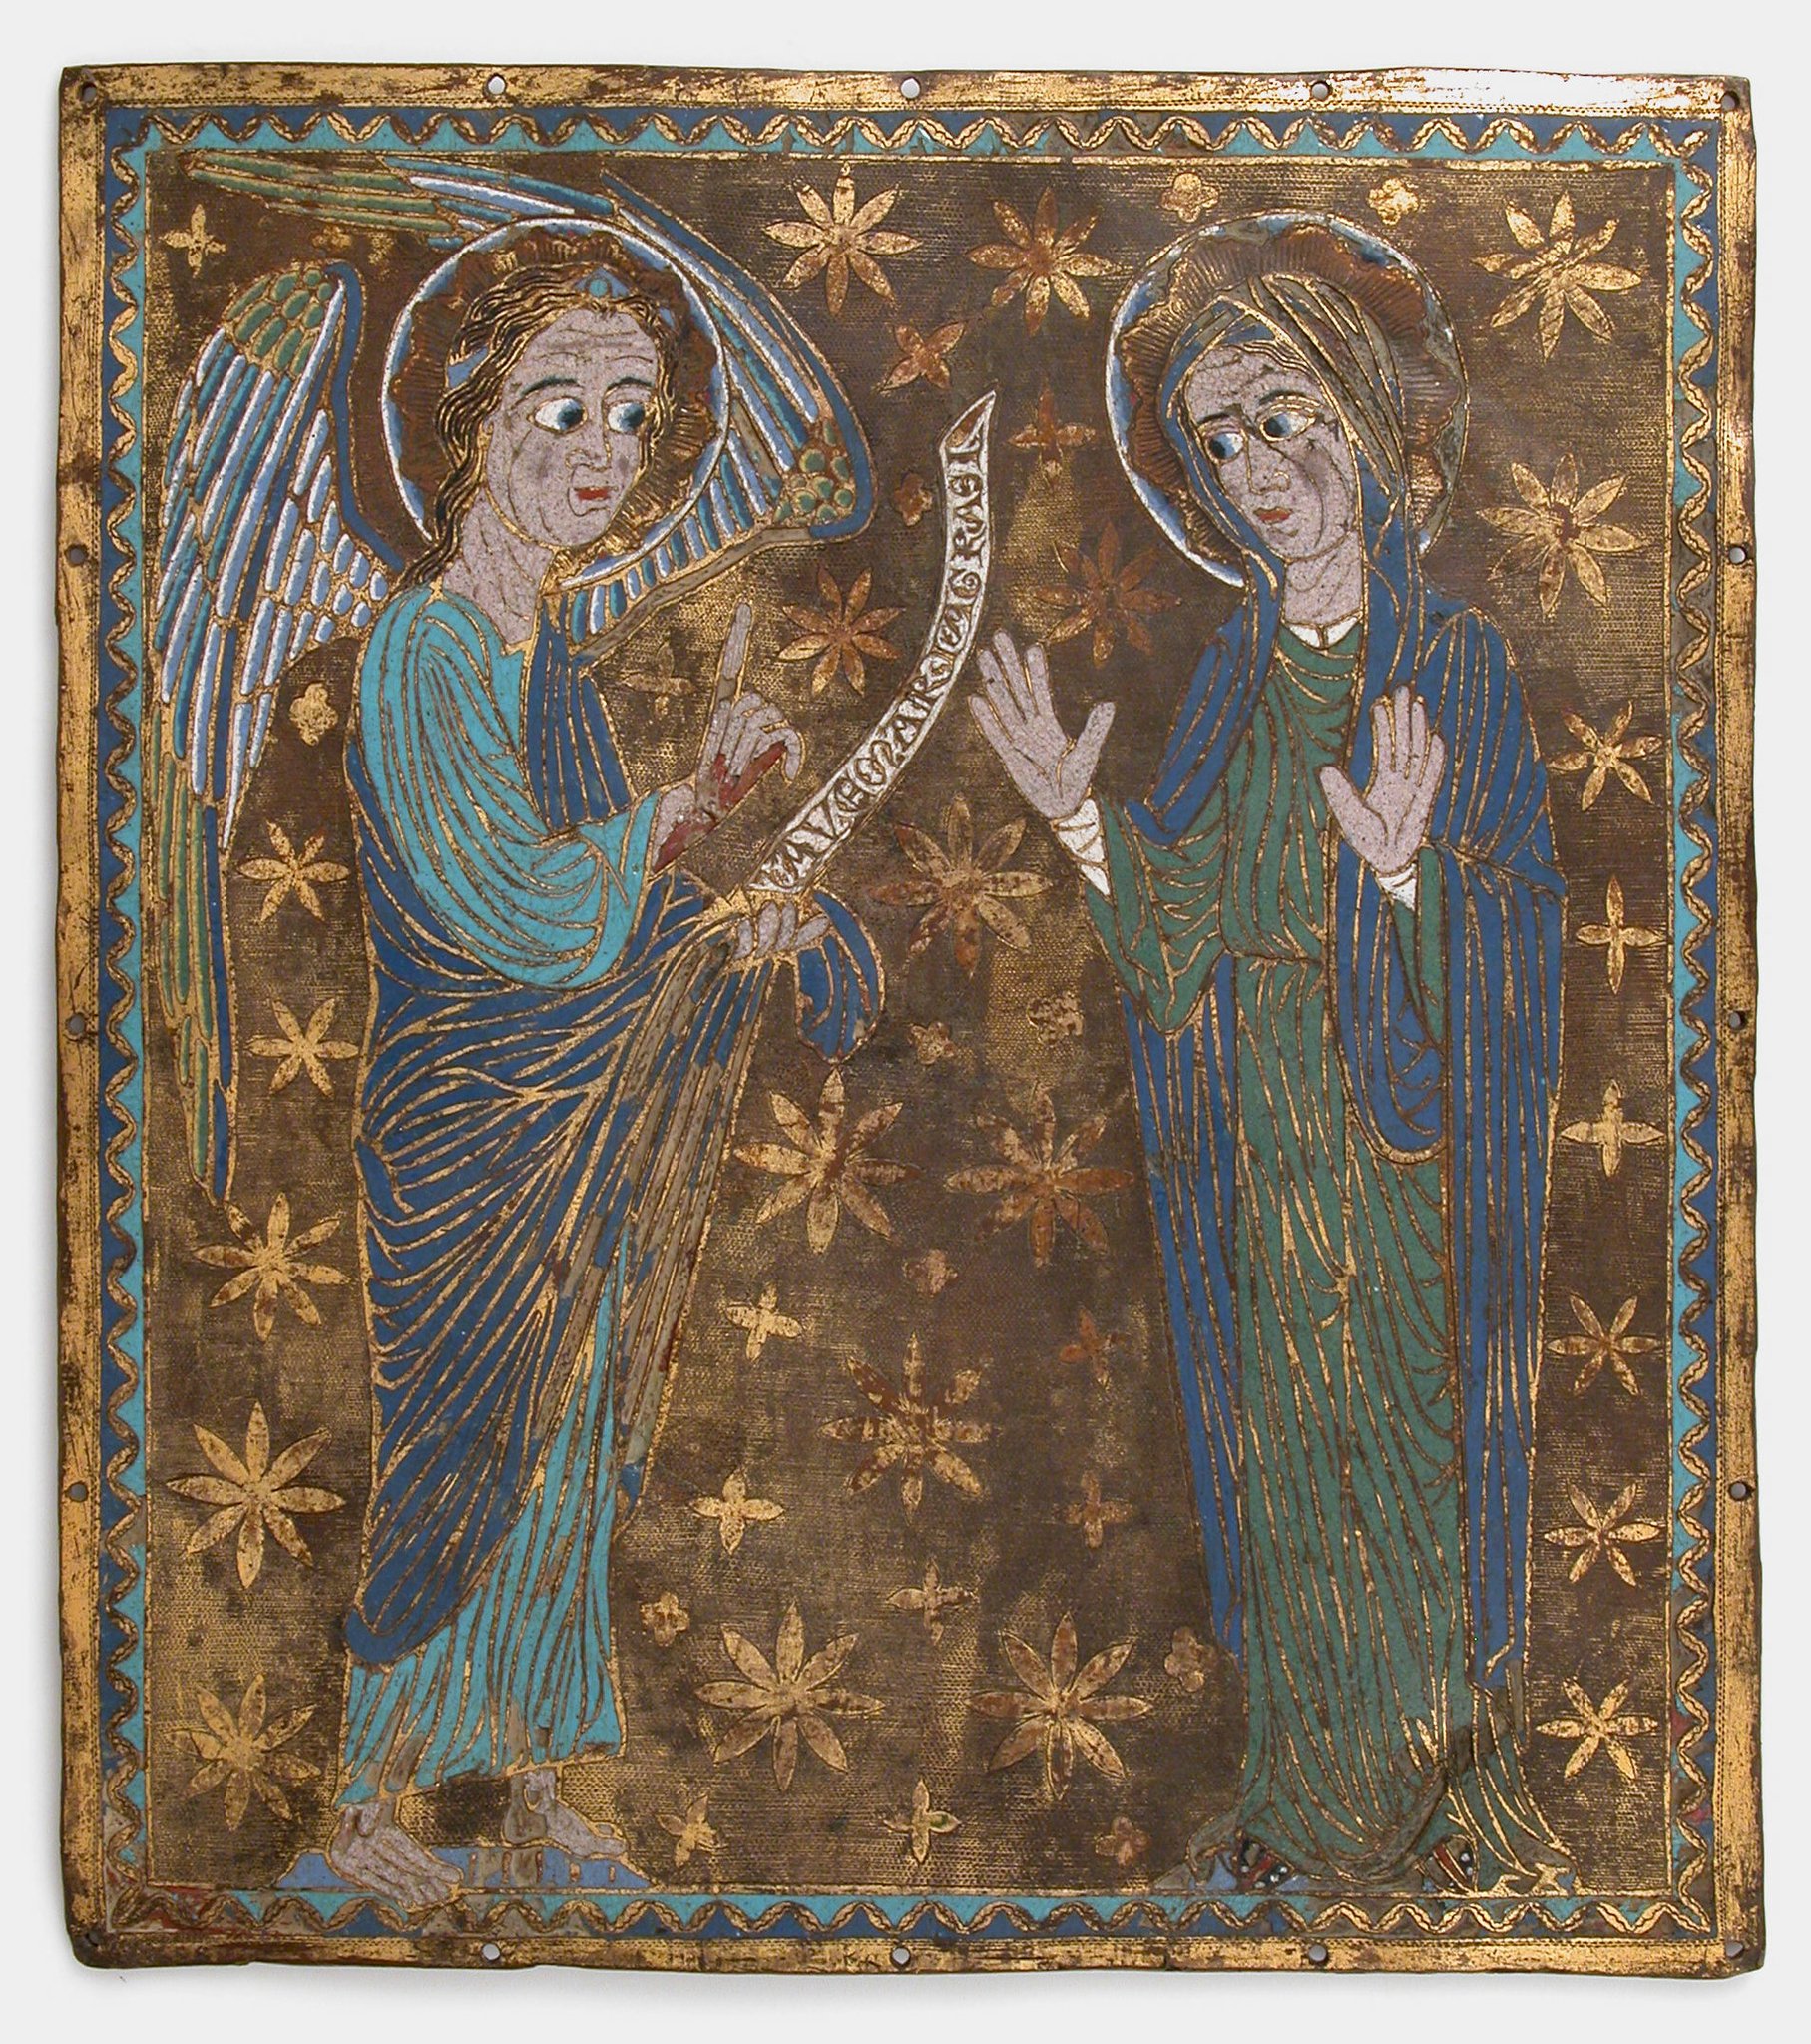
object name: plaque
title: Plaque with the Annunciation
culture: catalan or italian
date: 1200-1225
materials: gilt copper, enamel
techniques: enamel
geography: central italy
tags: angels,virgin mary